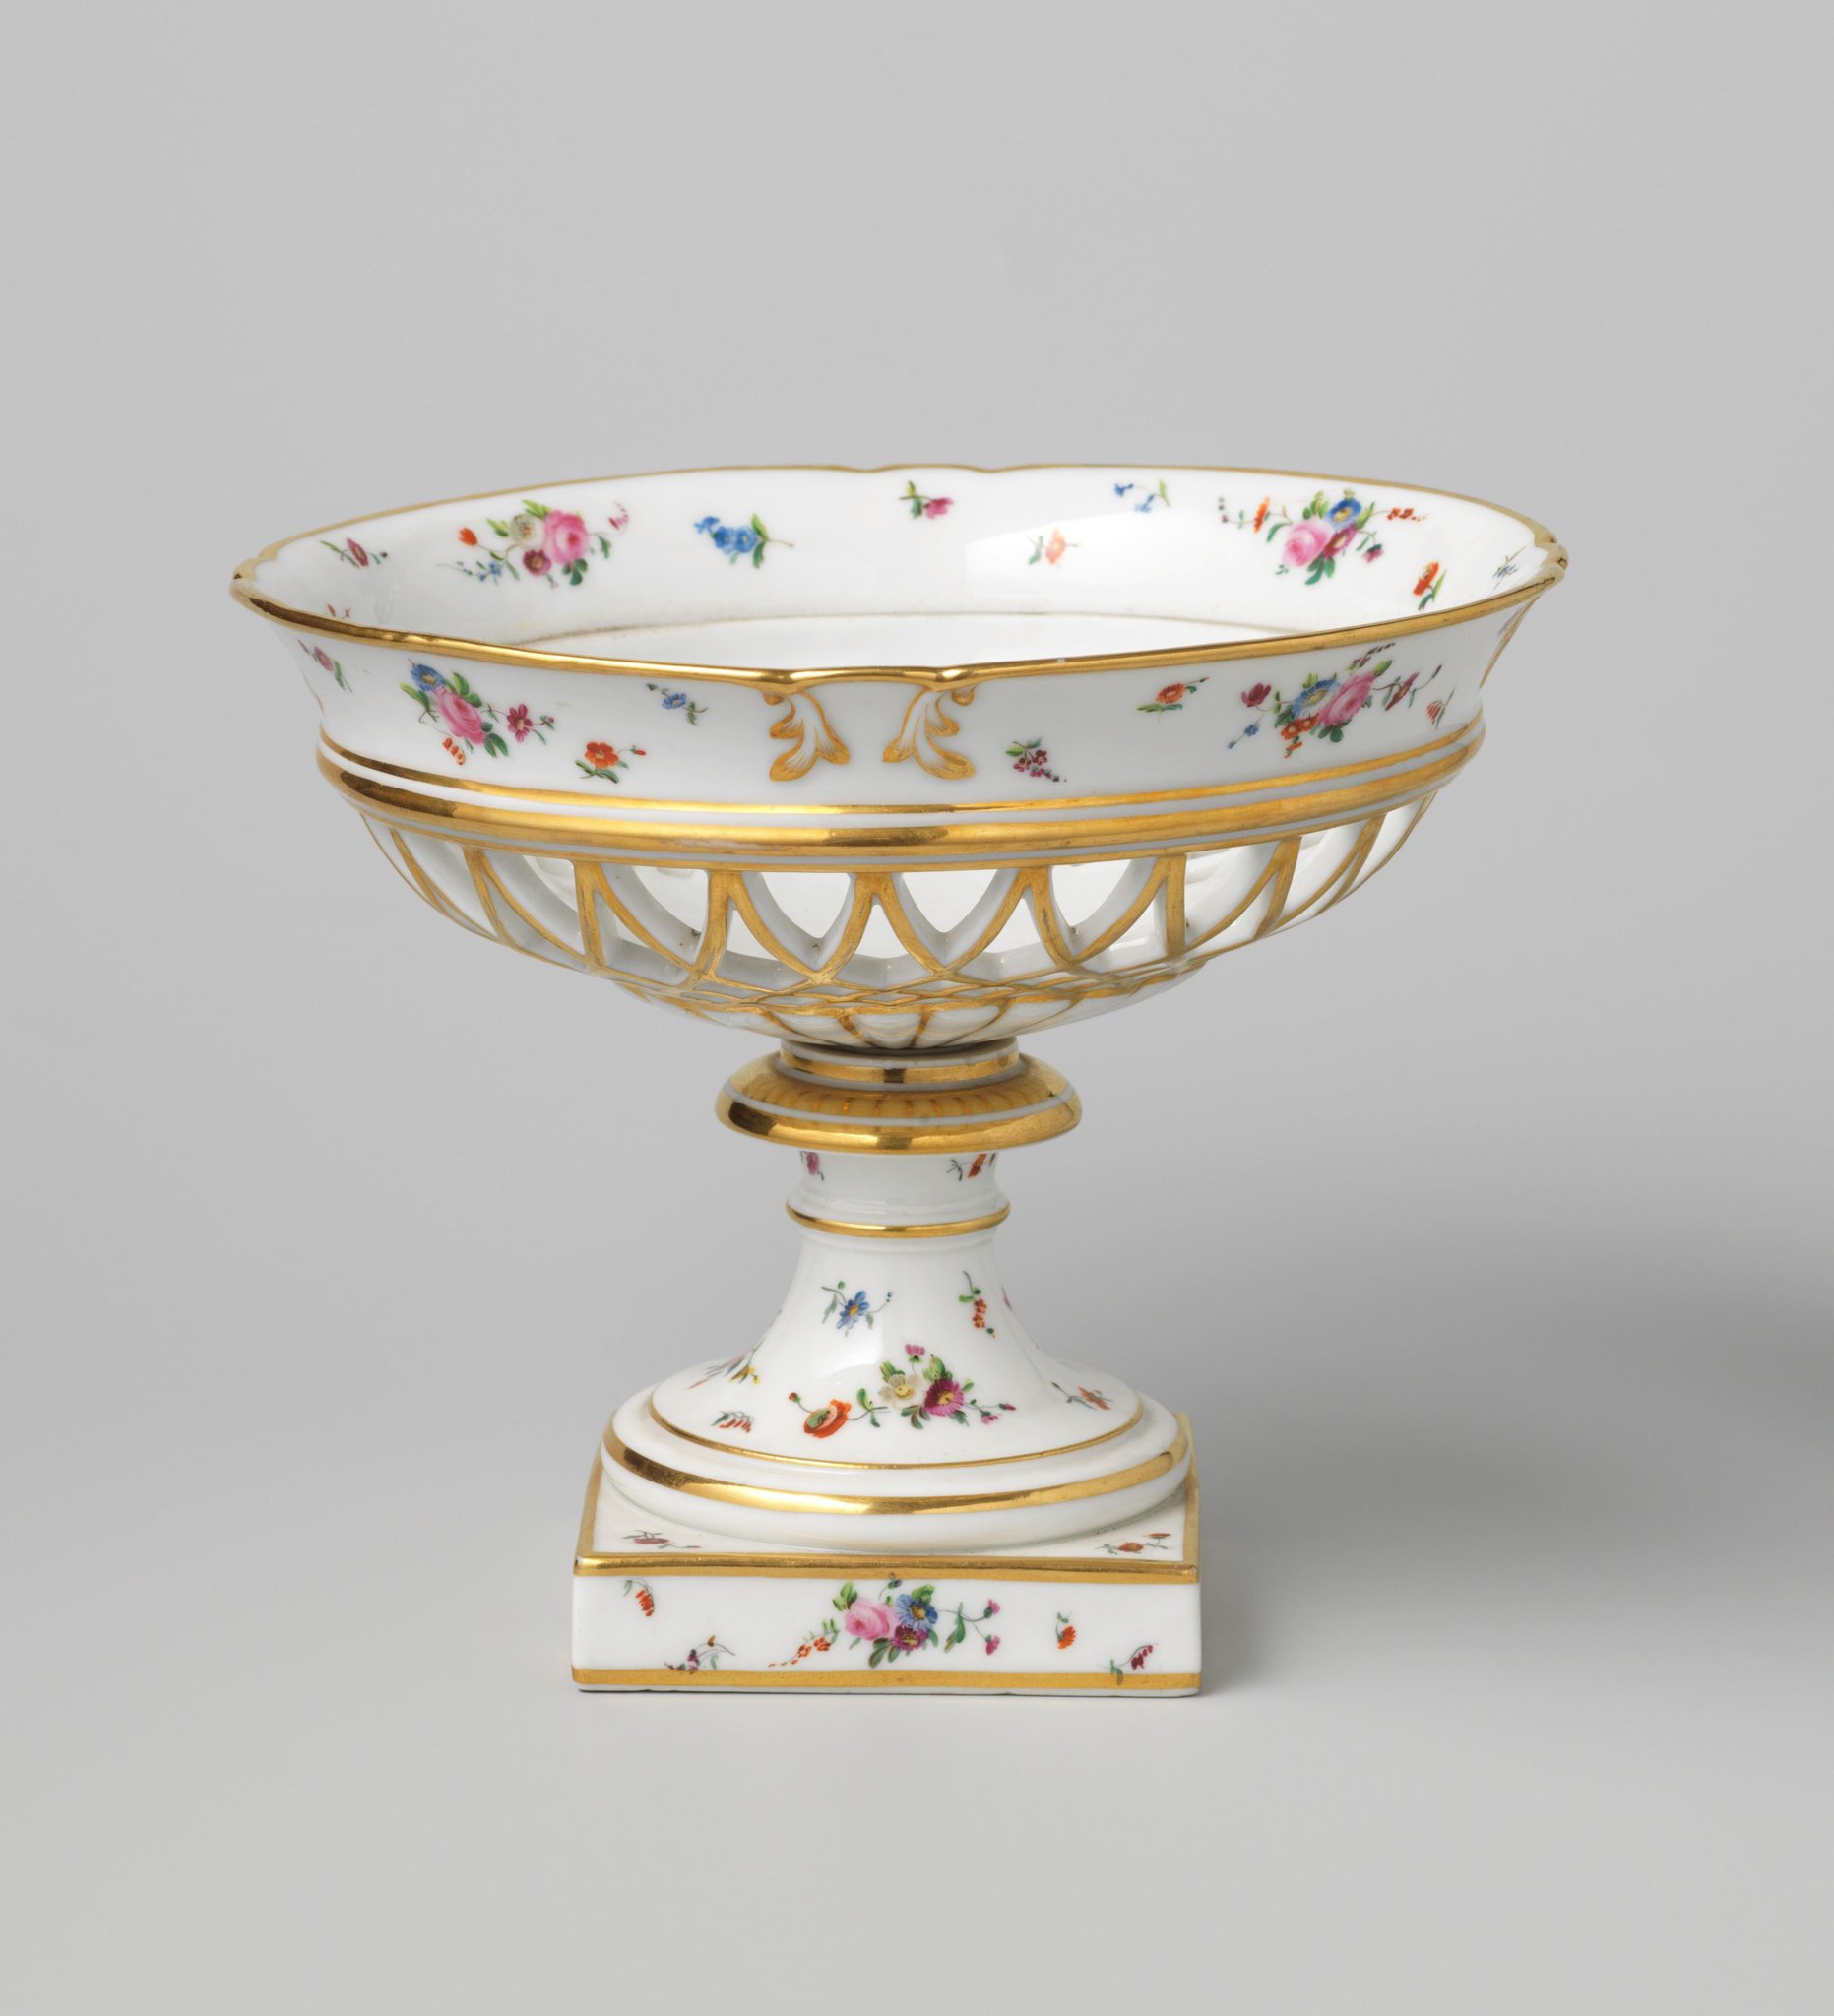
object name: service set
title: Base with bouquets and flower sprays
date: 1839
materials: glaze, gold, paint, porcelain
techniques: embroidery, firing, forming, gilding, turning, vitrification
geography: paris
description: Voetstuk van een schaal (fruitschaal) van porselein met een gelobde rand, beschilderd op het glazuur in blauw, rood, roze, groen, geel, paars, zwart en goud. De ronde voet loopt door in een vierkant voetstuk. Versierd met boeketten van verschillende bloemen, strooibloemen en gouden lijnen.